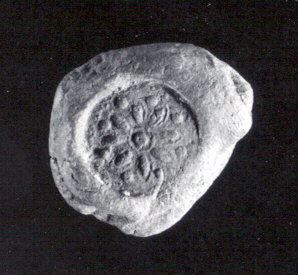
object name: sealing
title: Sealing with stamp seal impression: rosette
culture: assyrian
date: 1800-1701 BCE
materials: ceramic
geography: anatolia